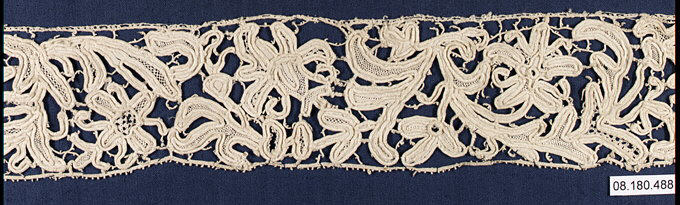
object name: border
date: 1667-1700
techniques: lace